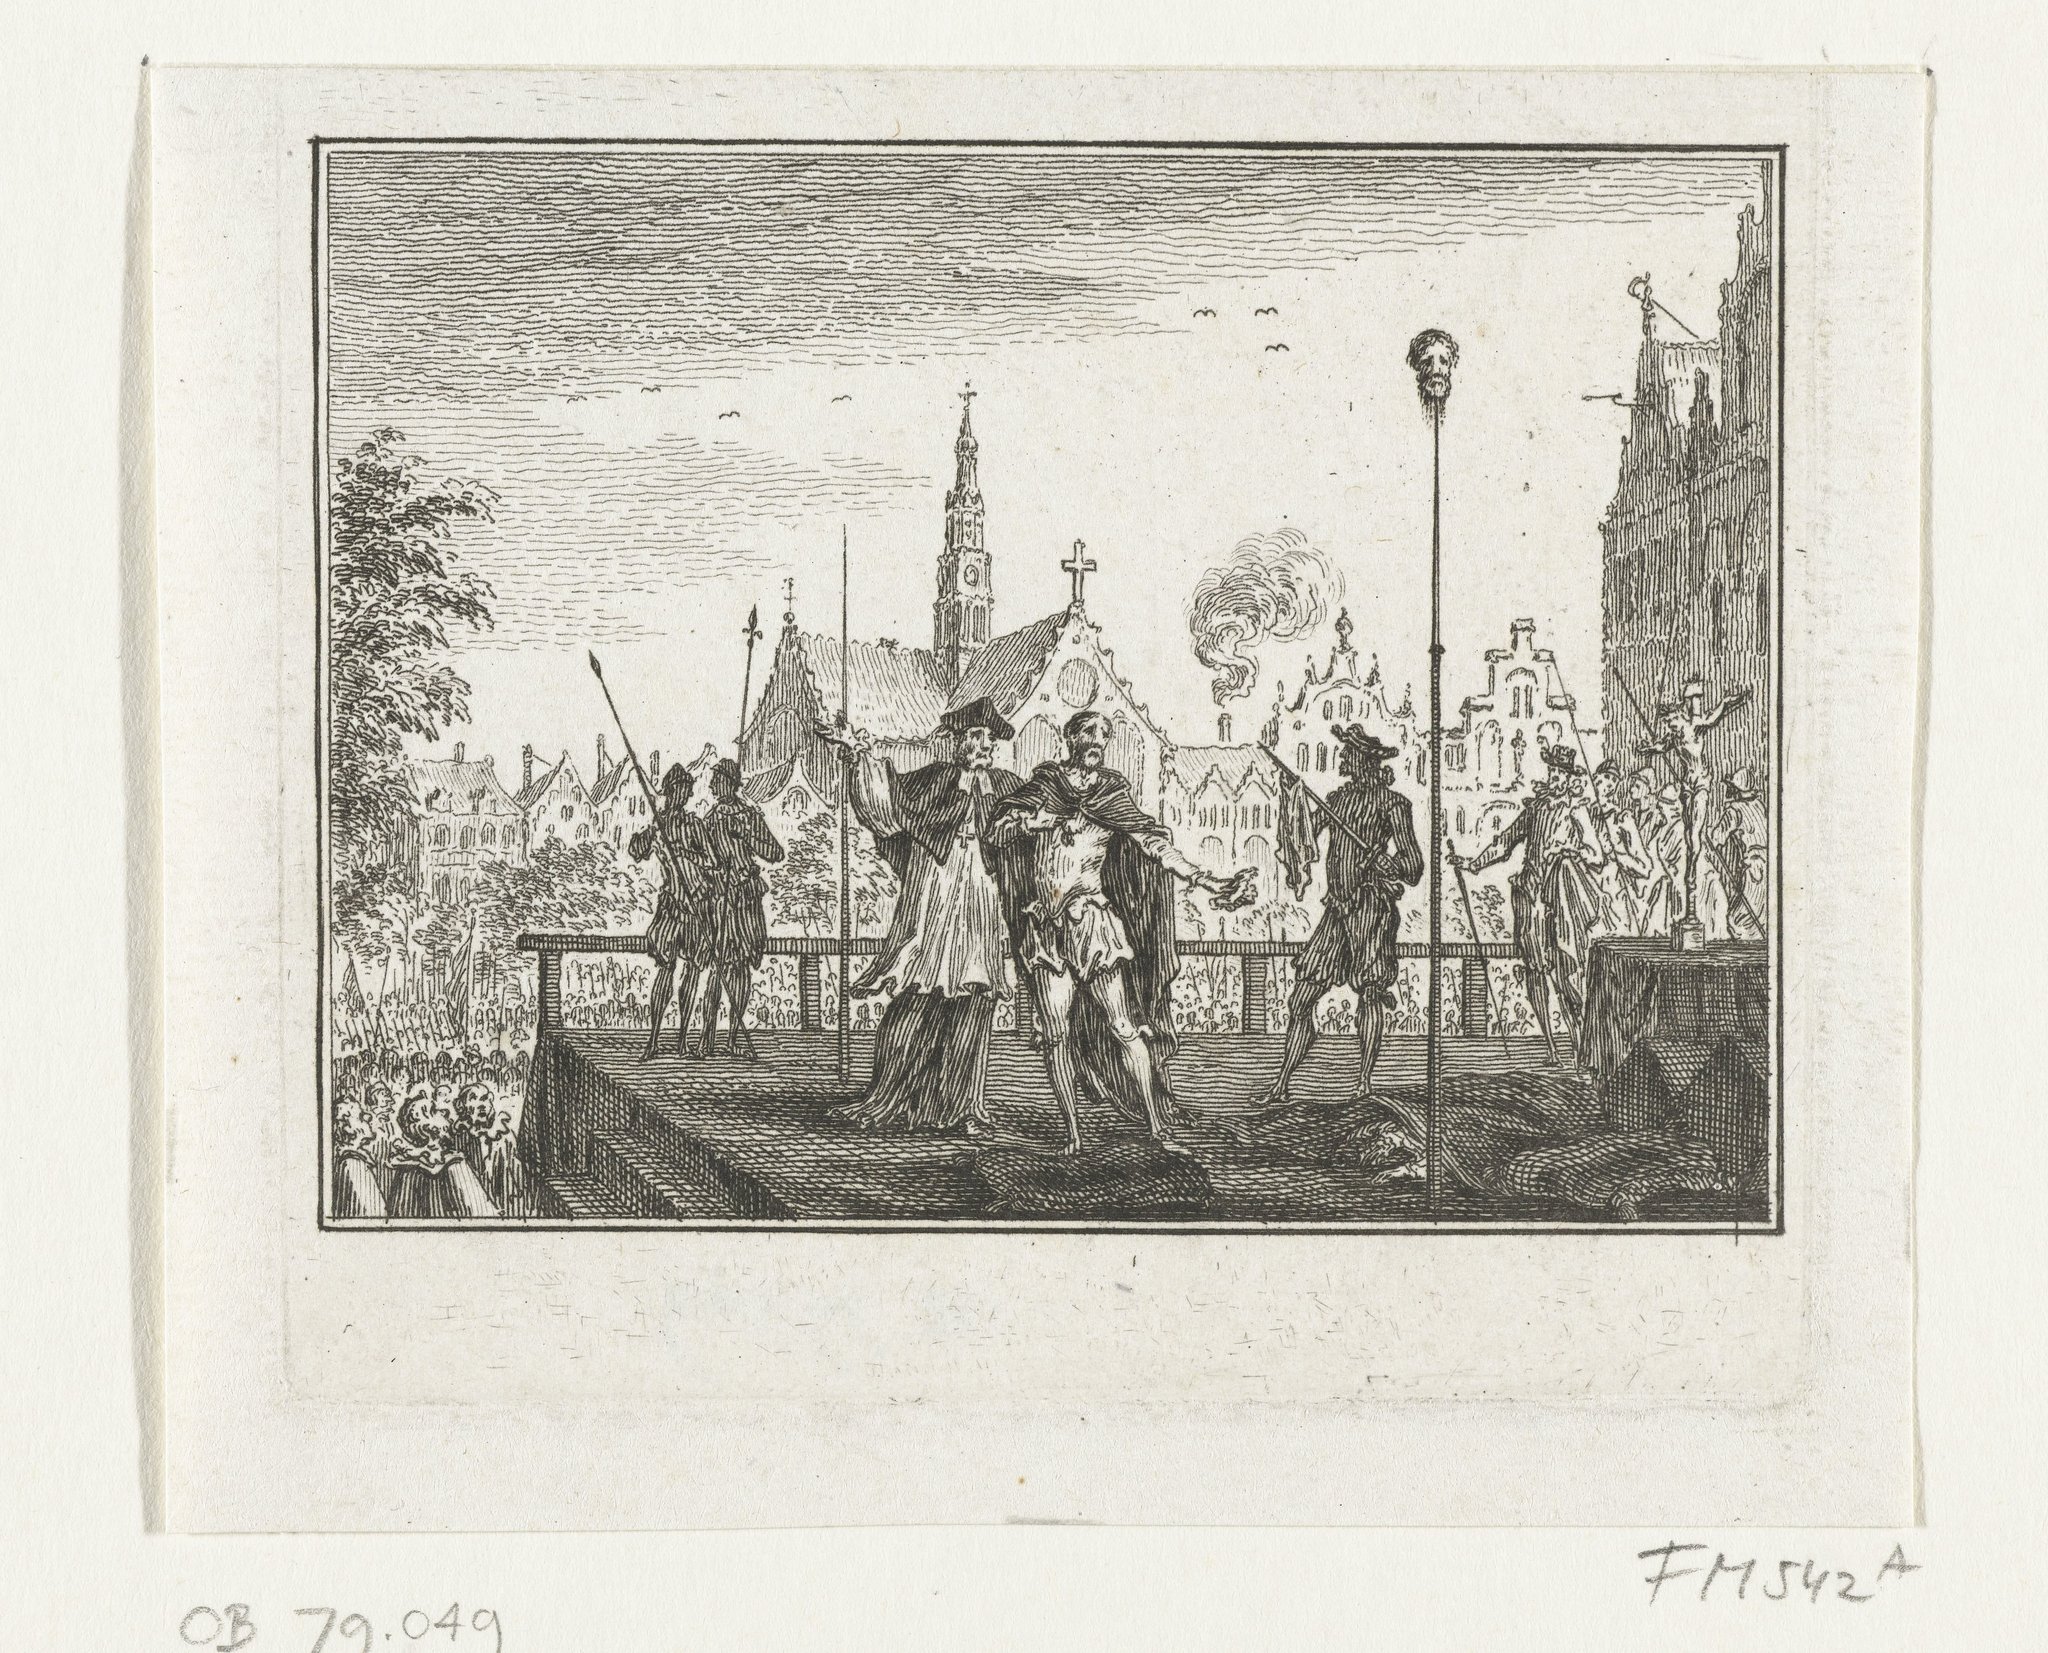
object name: print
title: Egmond op het schavot, 1568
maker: simon fokke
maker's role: draughtsman, print maker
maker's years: 1712-1784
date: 1782-1784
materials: paper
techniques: etching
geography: northern netherlands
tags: brussels, earl, on the scaffold or place of execution, violent death by beheading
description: Illustratie voor: J.W. te Water, De vaderlandsche Historie van den heere J. Wagenaar, verkort, en met leerzaame aanmerkingen, ten dienste der Nederlandsche jeugd, 1784-1800, 4 delen. Staat vóór de letter. Niet in Frederik Muller; door het RPK toegevoegd nummer.